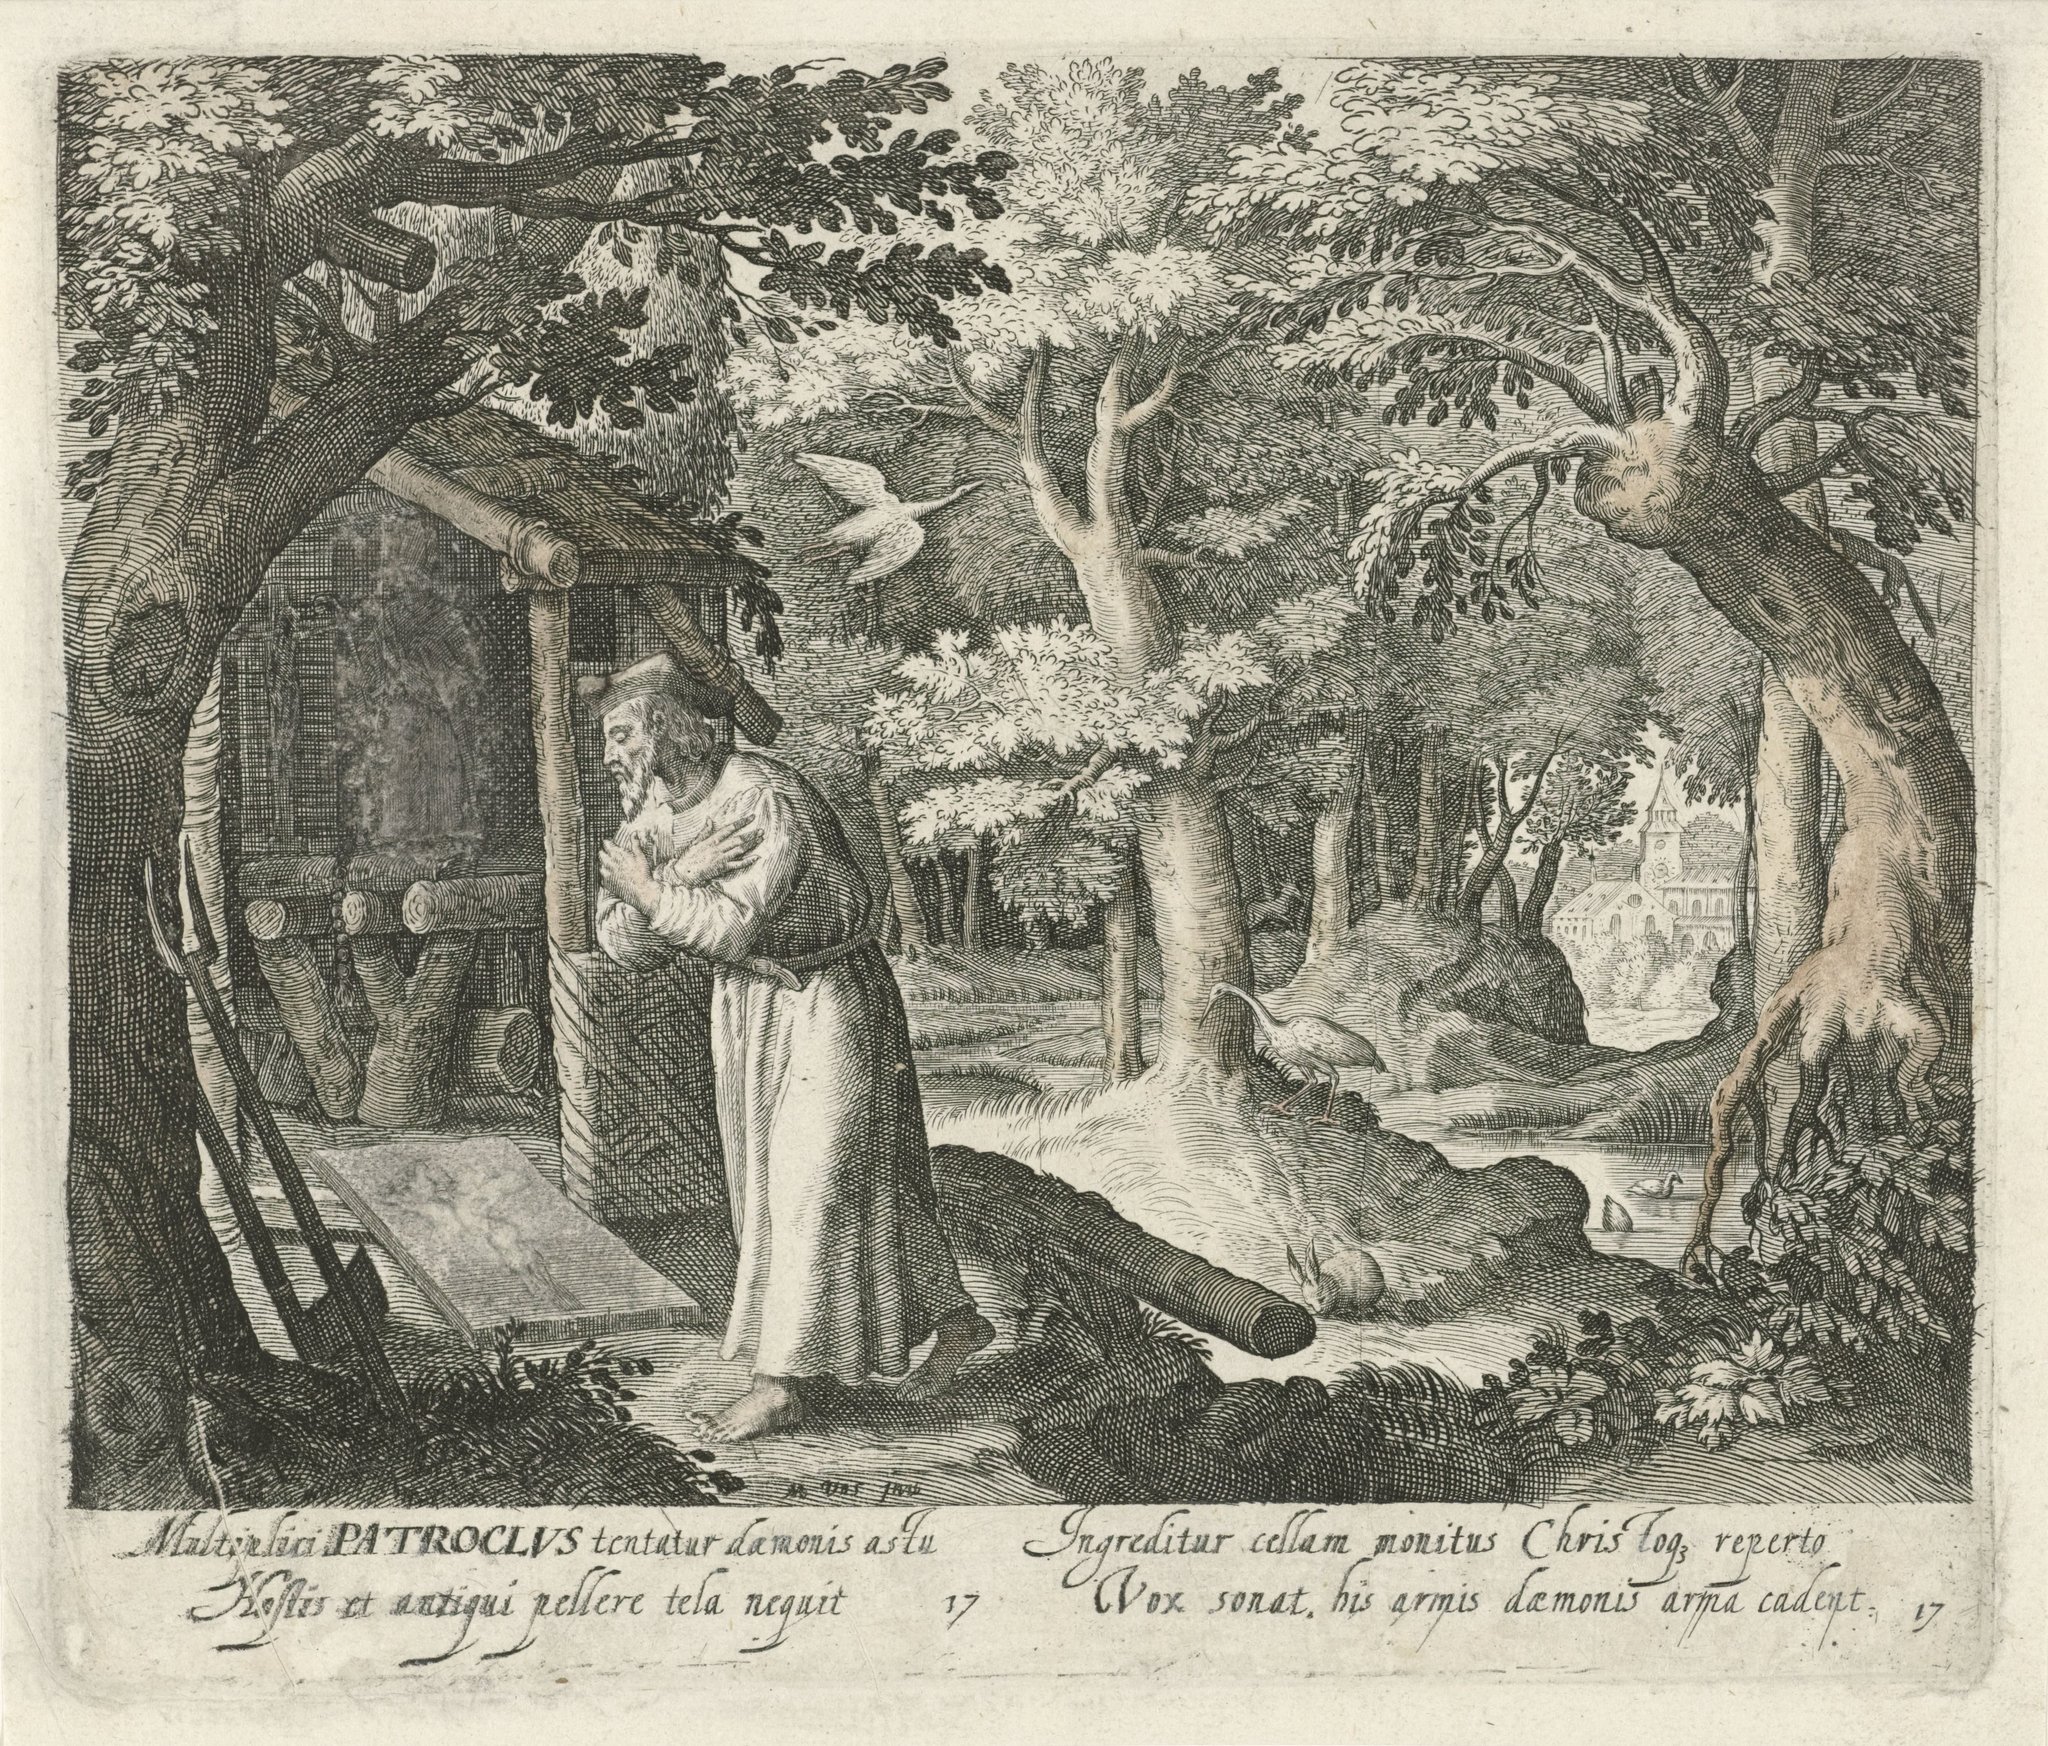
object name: print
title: Heiligen en kluizenaars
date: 1580-1625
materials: paper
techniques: brush, engraving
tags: male saints (with name), forest, wood, anchorite, hermit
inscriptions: collector's mark: Lugt 2228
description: De heilige Patroclus van Néris bij zijn kluizenaarshut in het bos in aanbidding voor de gekruisigde Christus. Op de achtergrond het klooster Colombier dat Patroclus voor zijn leerlingen liet bouwen. In de marge een onderschrift in Latijn.